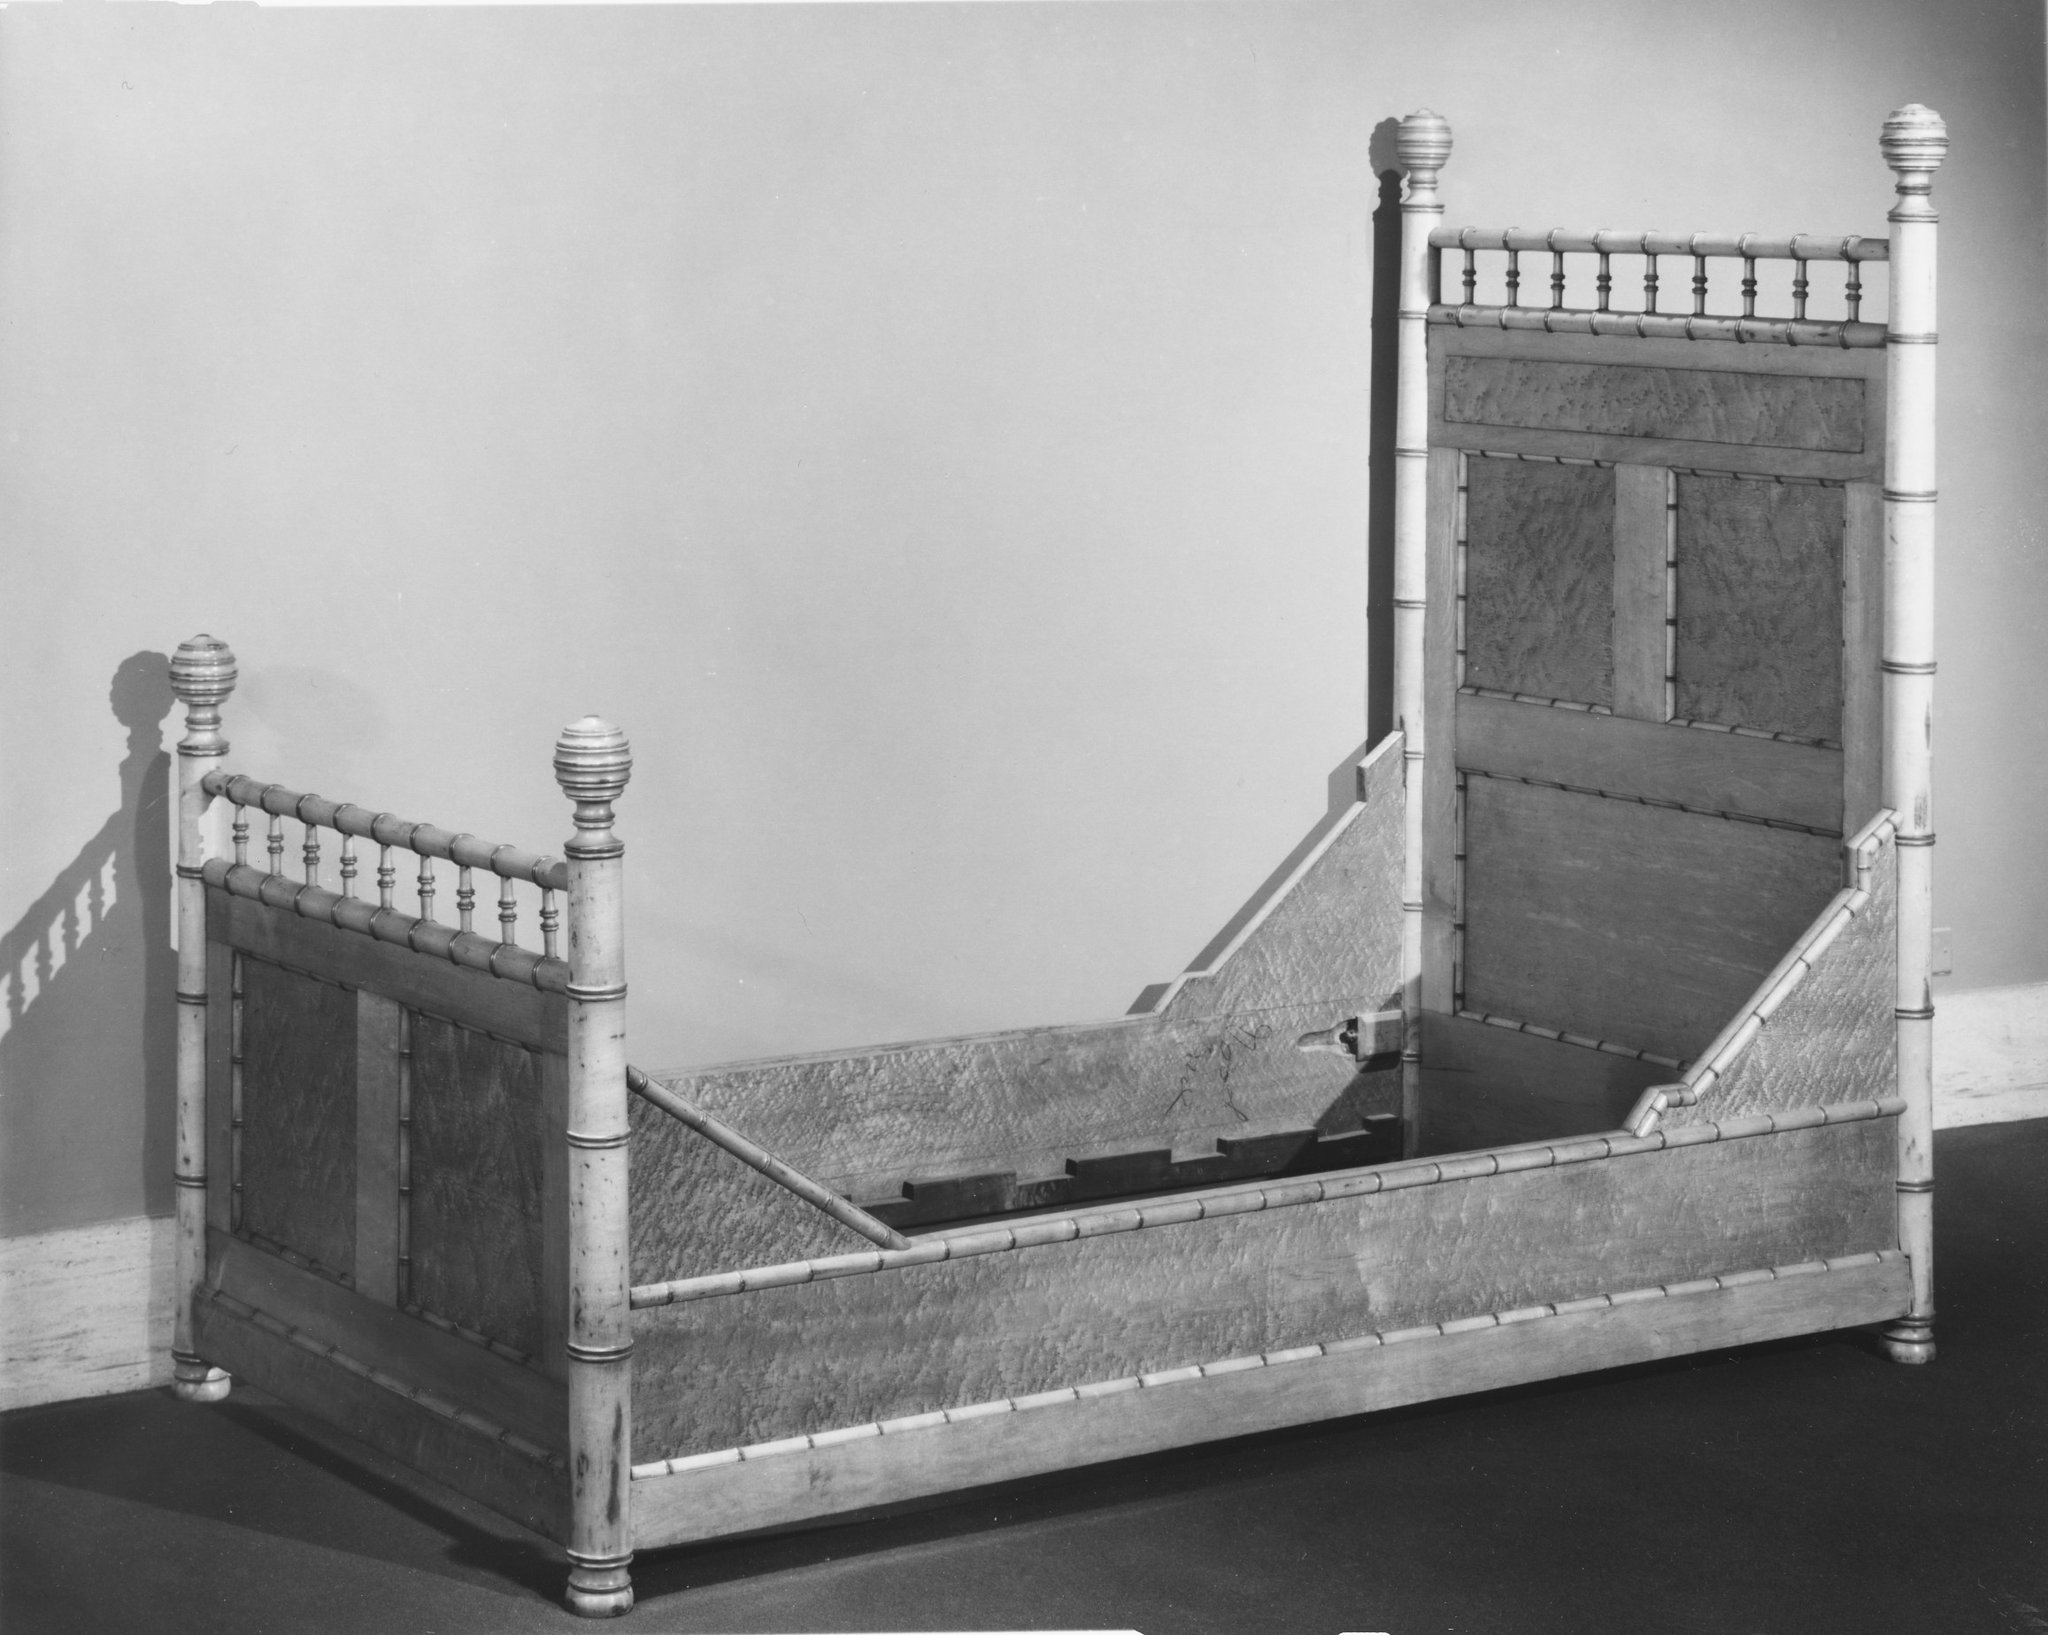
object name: bedstead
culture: american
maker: baumann brothers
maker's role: maker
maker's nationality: american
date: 1880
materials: wood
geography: united states